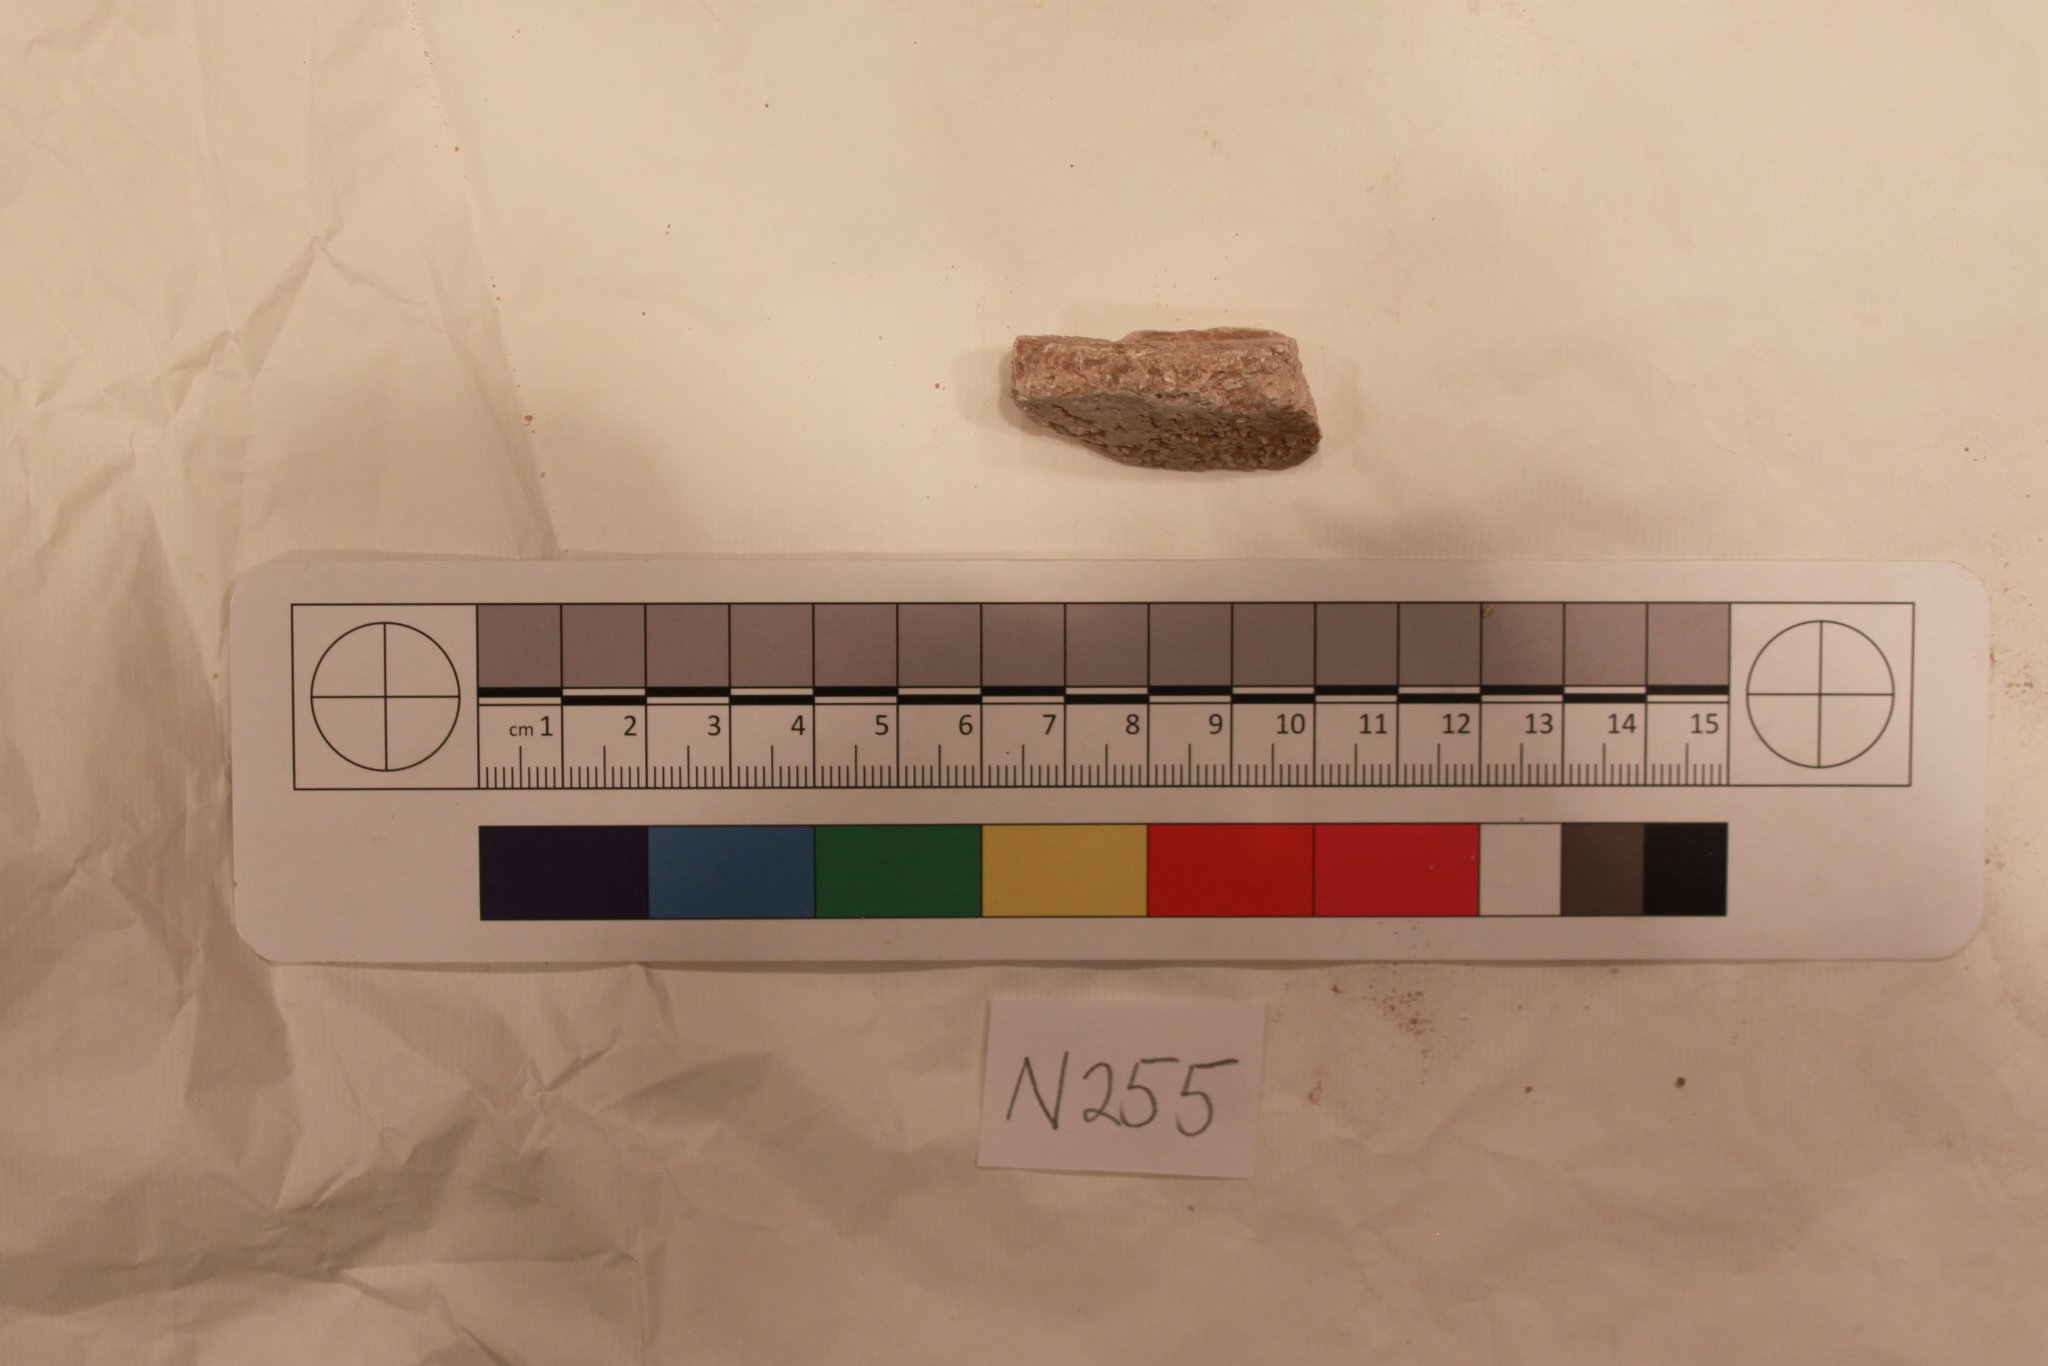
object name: fragment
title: Stucco Fragment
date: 701-1200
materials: plaster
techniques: carving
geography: iran